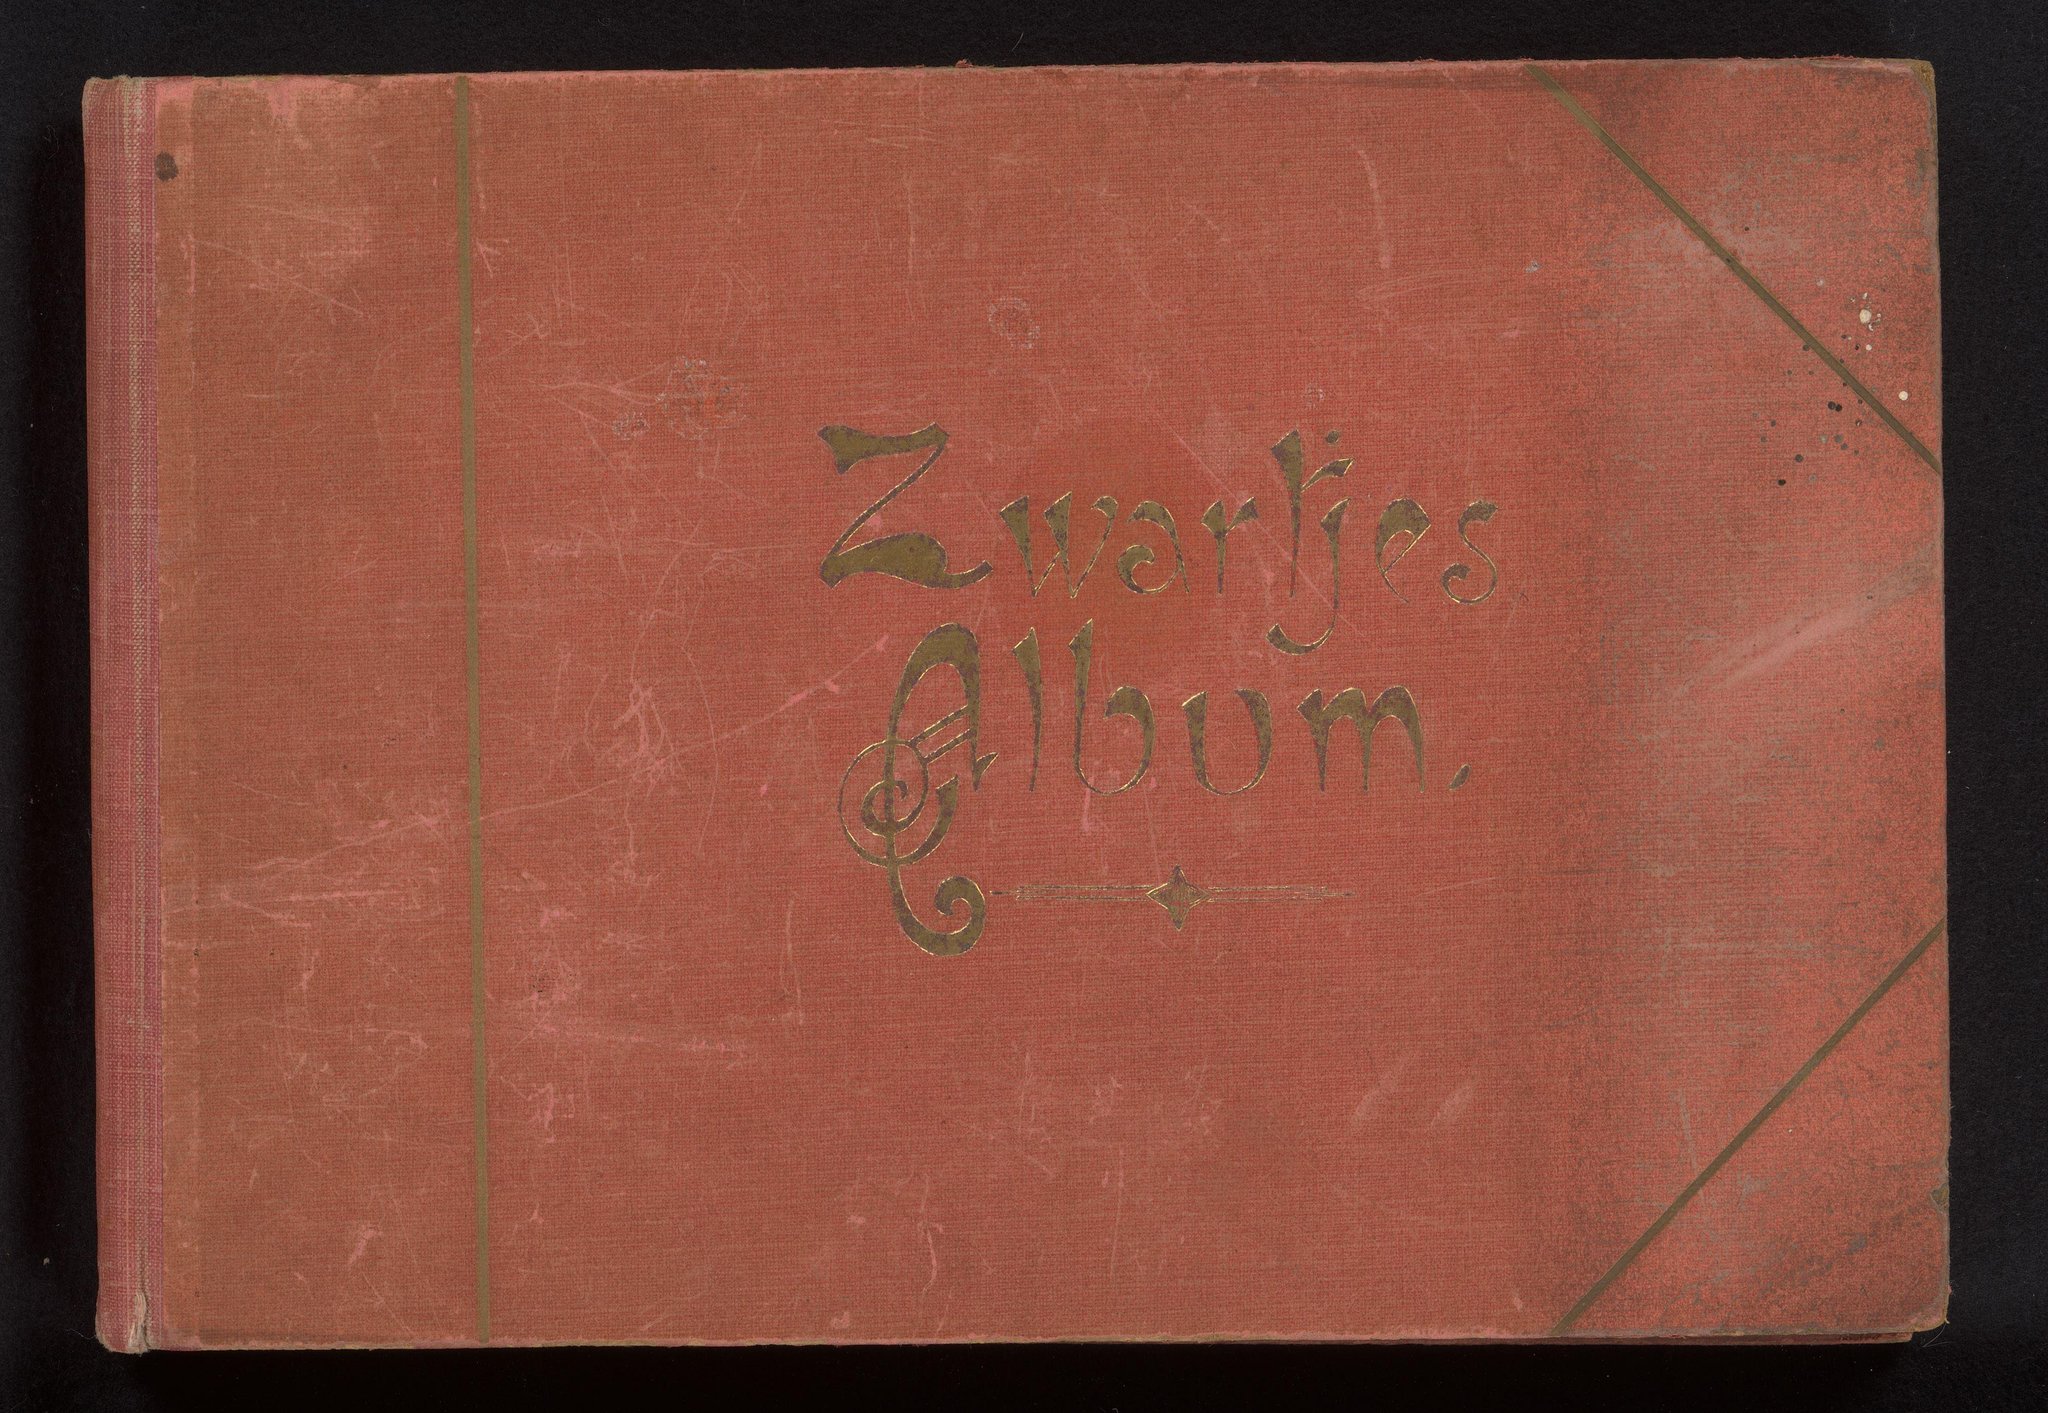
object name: photograph album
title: Verzamelalbum met kinderportretten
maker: Anonymous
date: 1880-1910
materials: cardboard, linen, photographic support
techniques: printing, photograph, gelatin silver print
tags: boy (child between toddler and youth), girl (child between toddler and youth), dog, child (at home)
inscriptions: annotation: ‘RE’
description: Zwartjesalbum met in totaal 84 foto's en 44 fotomechanische afdrukken. Het album bevat voornamelijk portretten van kinderen, soms met dieren.